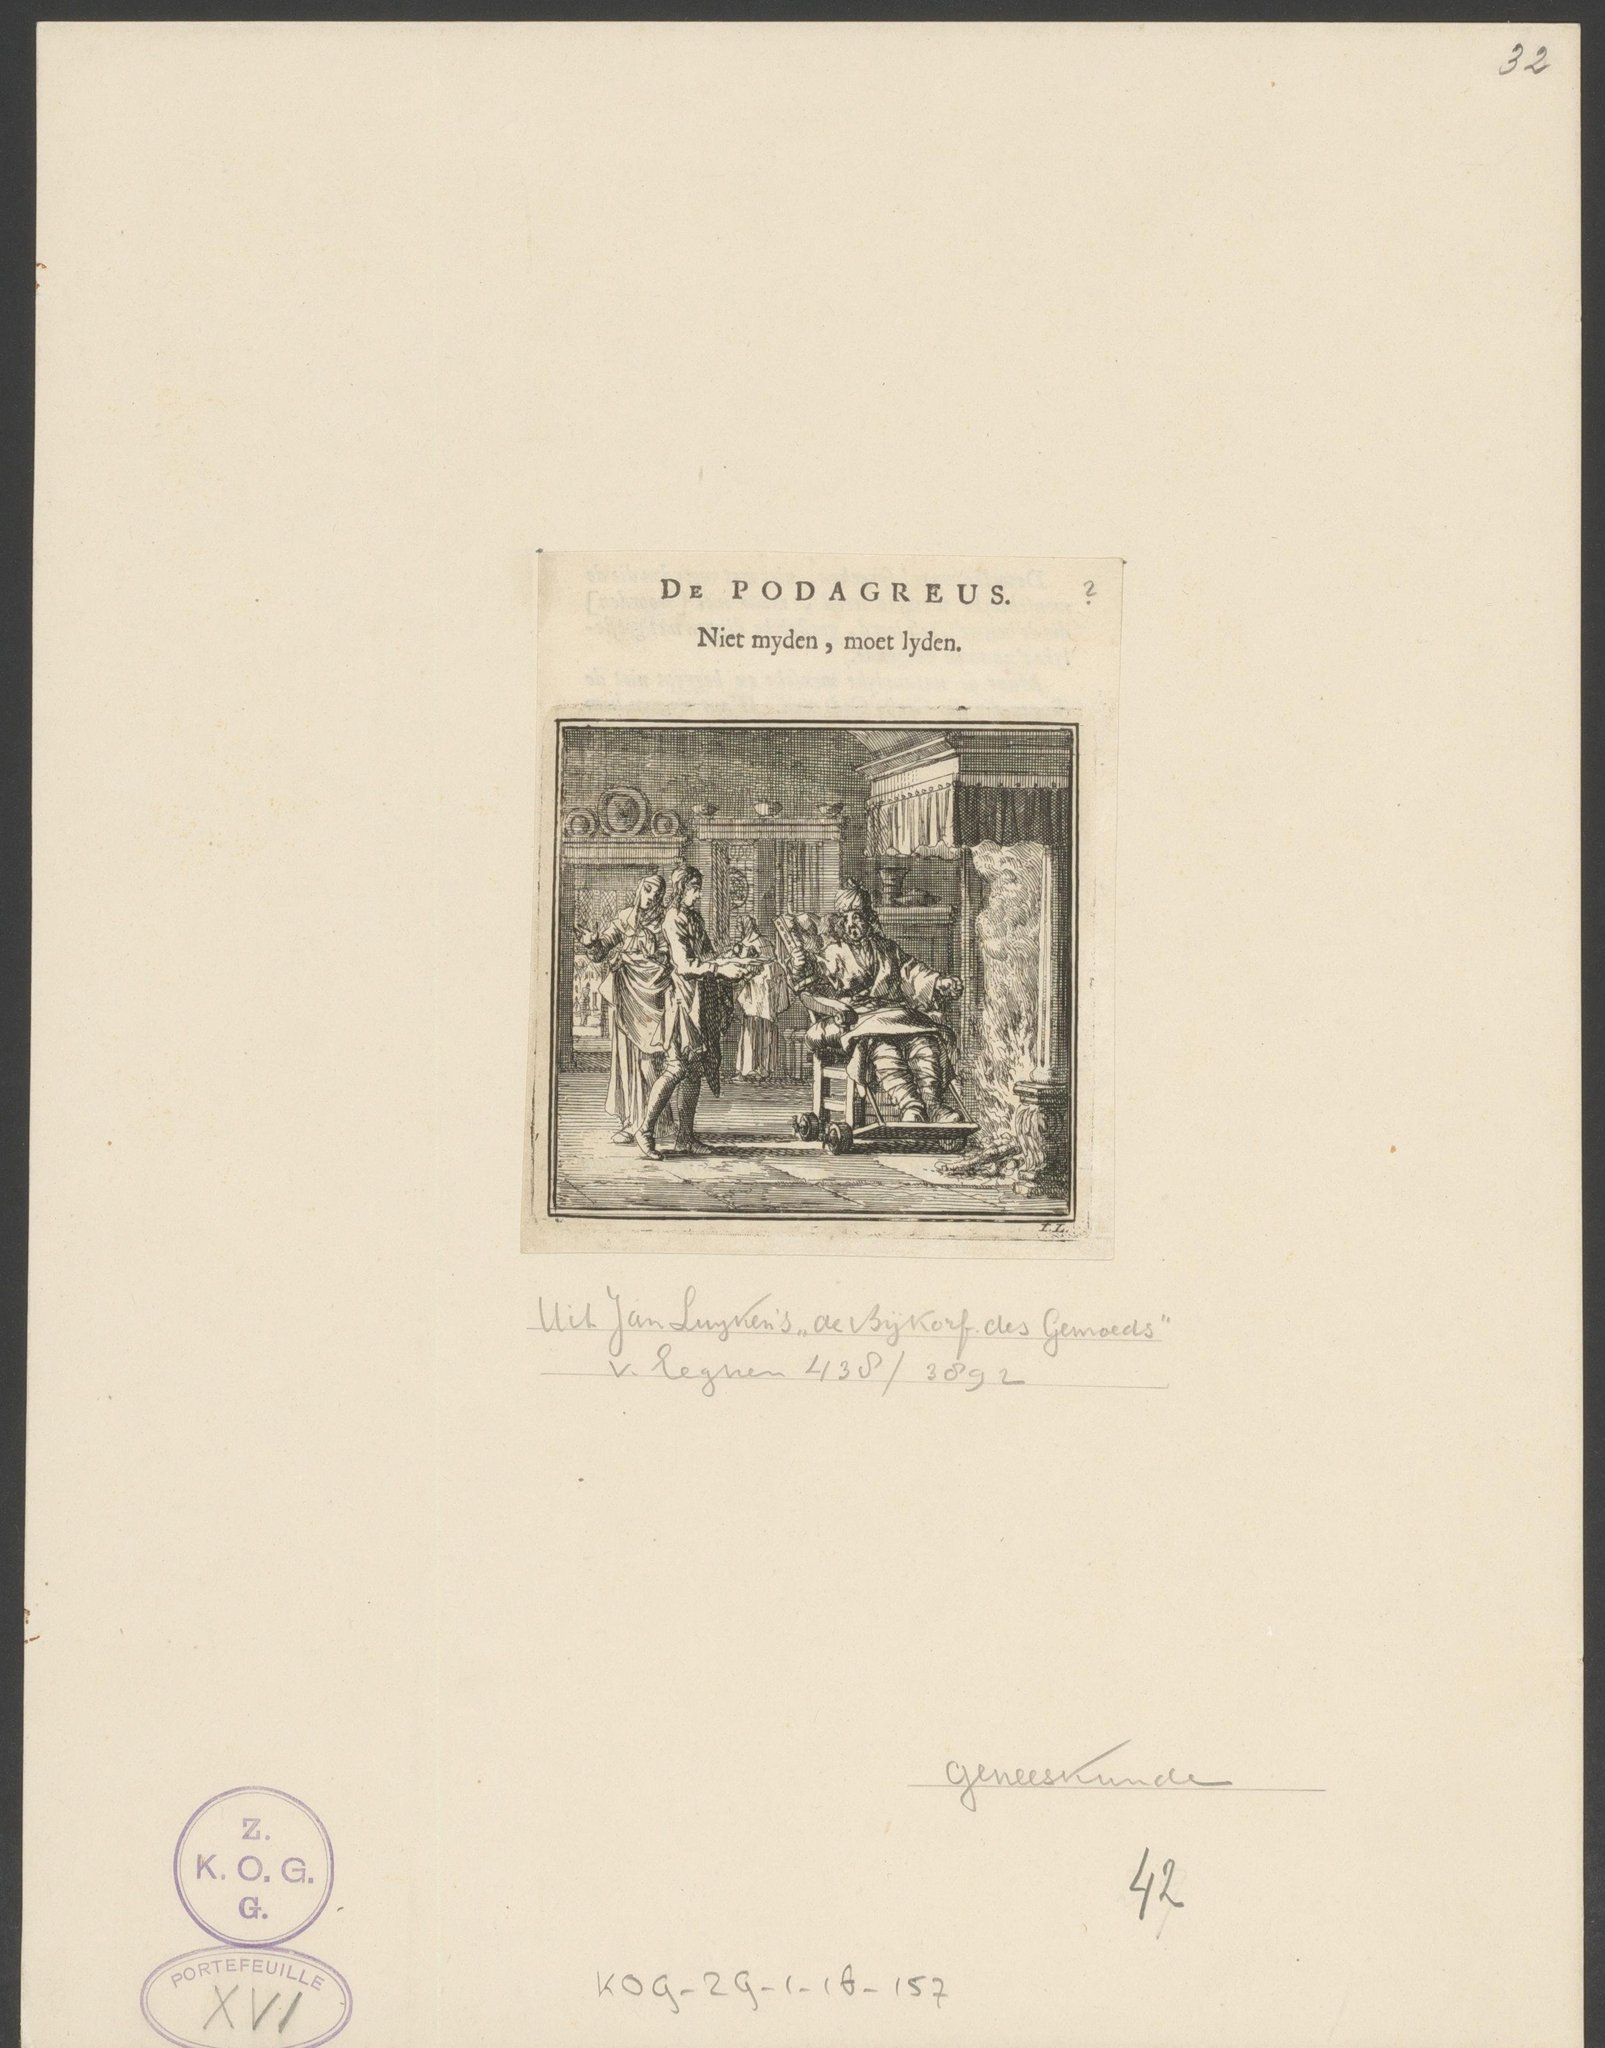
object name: book illustration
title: De Podagreus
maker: jan luyken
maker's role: draughtsman, print maker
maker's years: 1649-1712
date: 1711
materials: paper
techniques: etching, letterpress printing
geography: amsterdam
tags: warming oneself at a fire (or hearth, stove, fire-pan, brazier), nursing, tending the sick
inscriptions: collector's mark: Lugt 1641, collector's mark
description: Man met voetjicht krijgt eten geserveerd voor de openhaard. Bedrukt met tekst op achterzijde. Onderwerpsrubrieken binnen de Atlas Zeden en Gewoonten: Onderwijs en Wetenschappen: Geneeskunde.